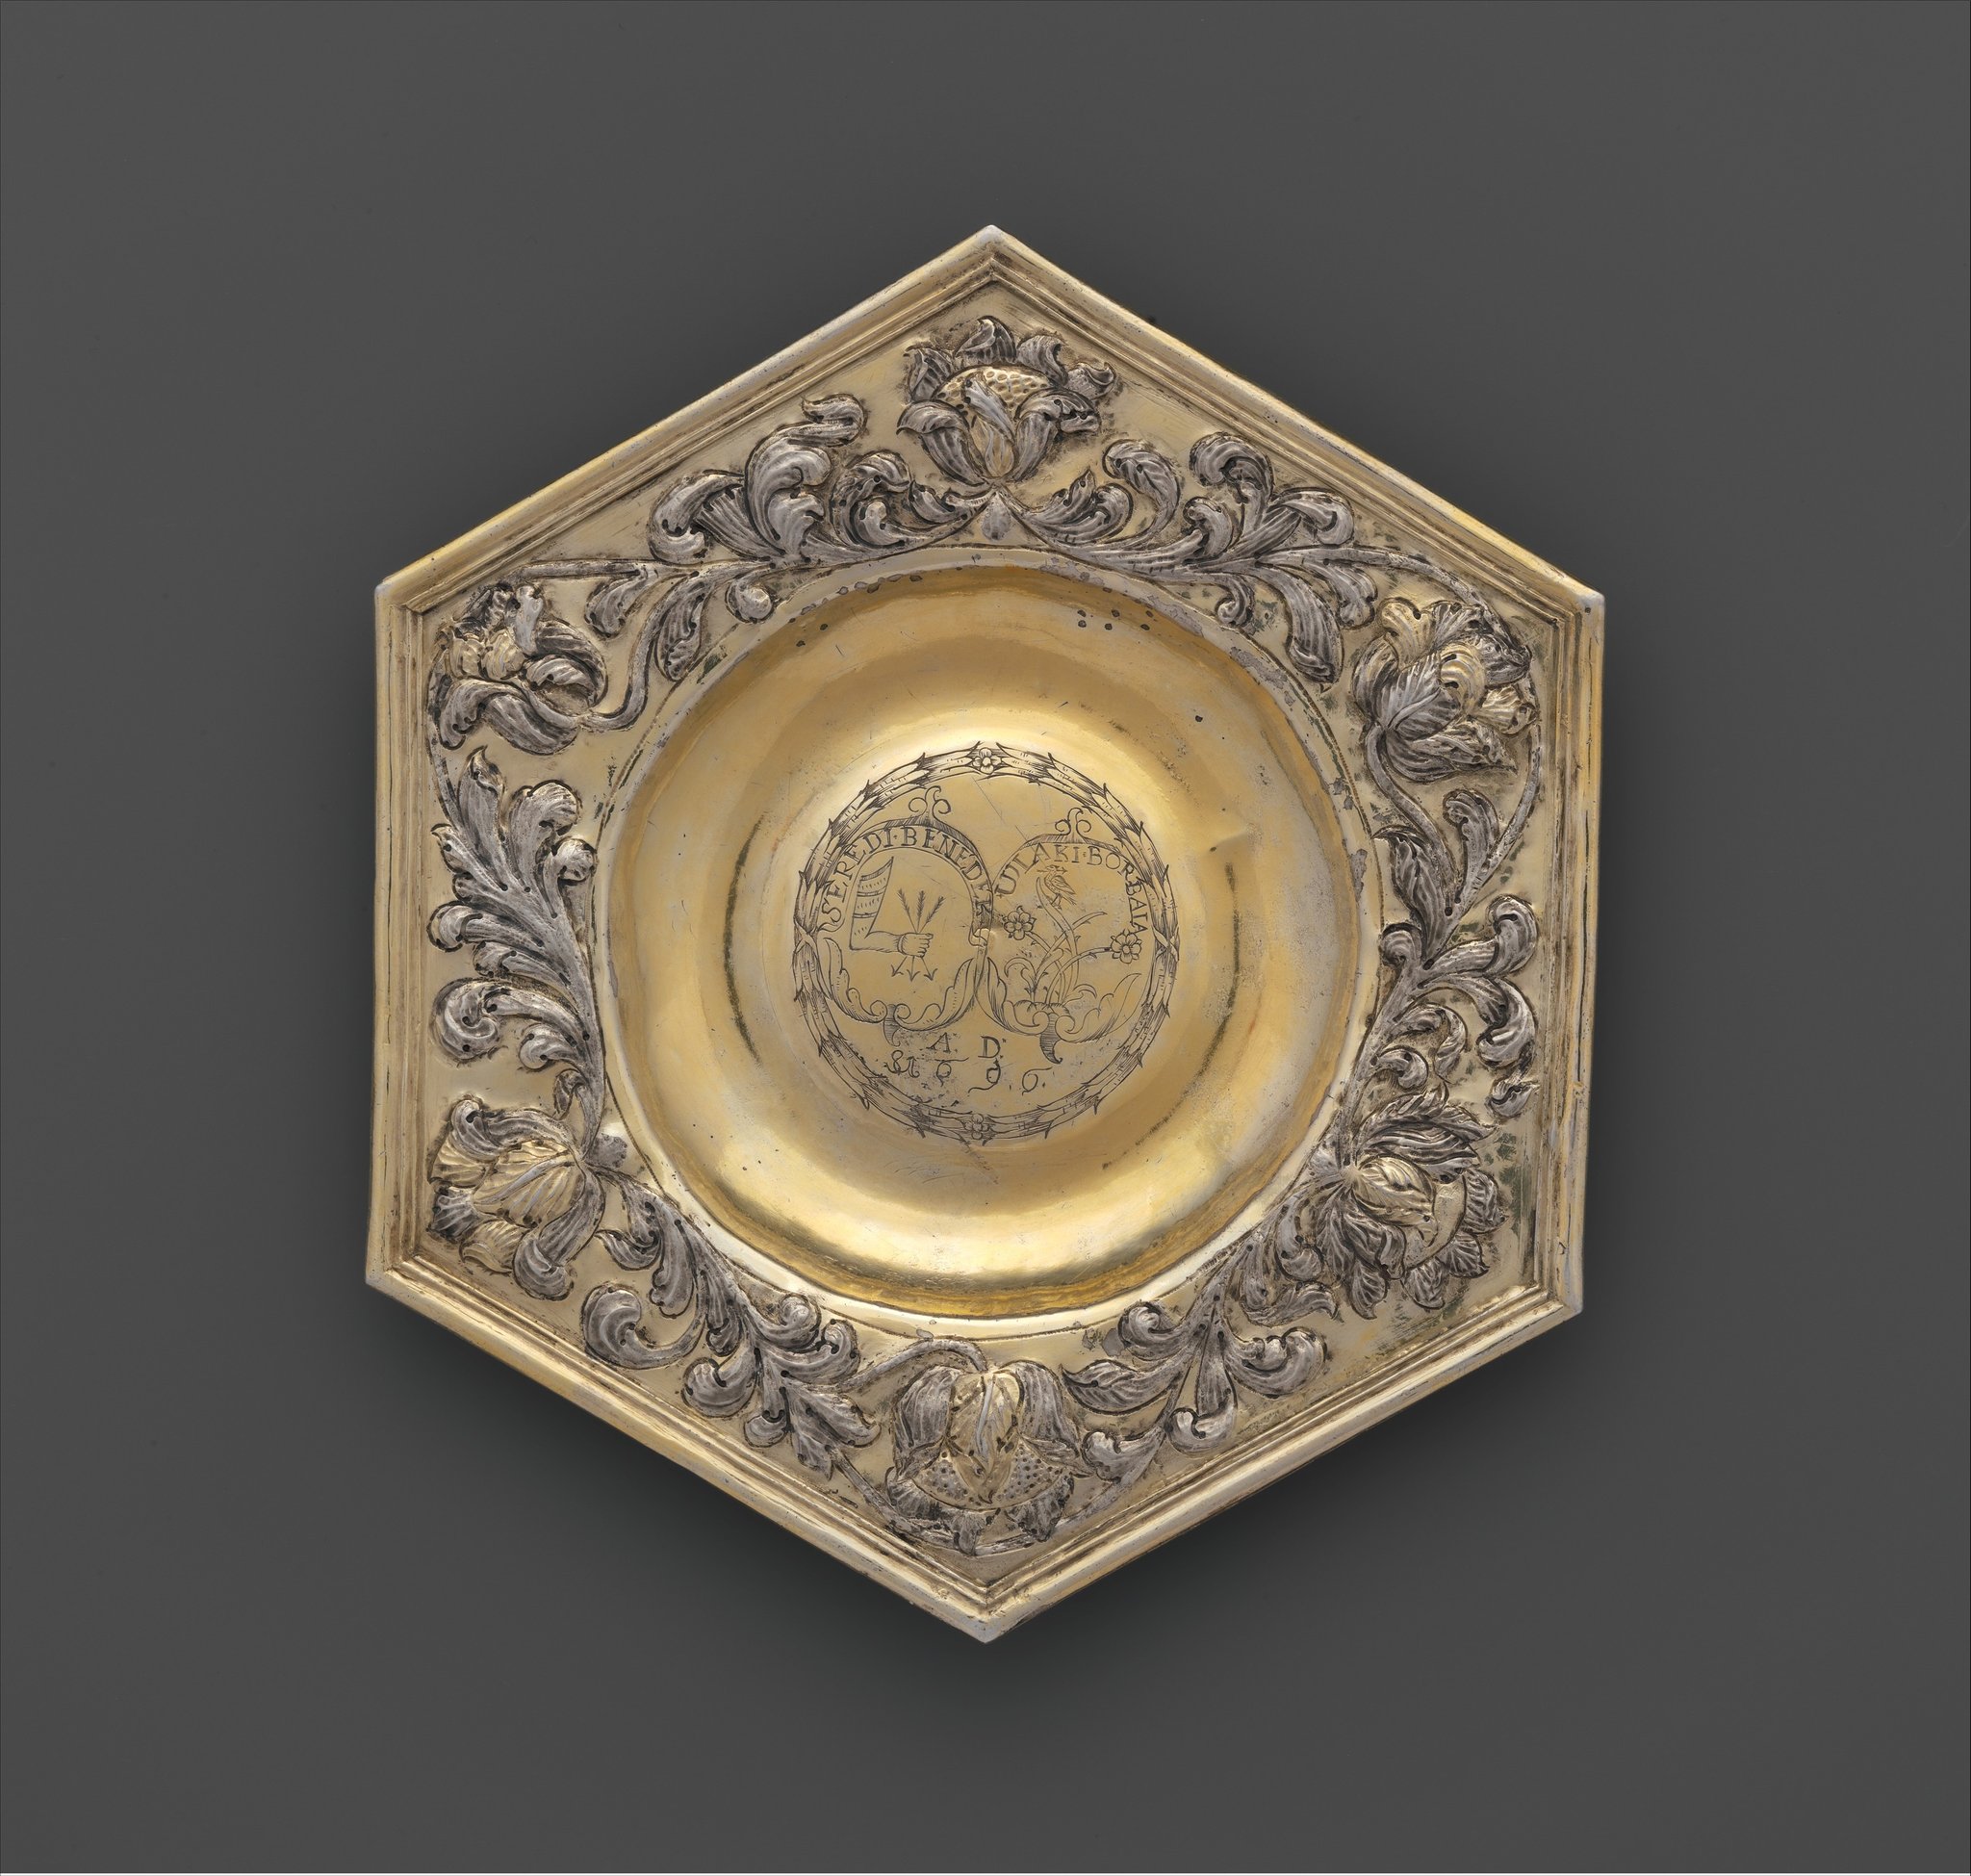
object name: dish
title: Hexagonal dish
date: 1696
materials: silver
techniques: gilding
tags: flowers,insignia